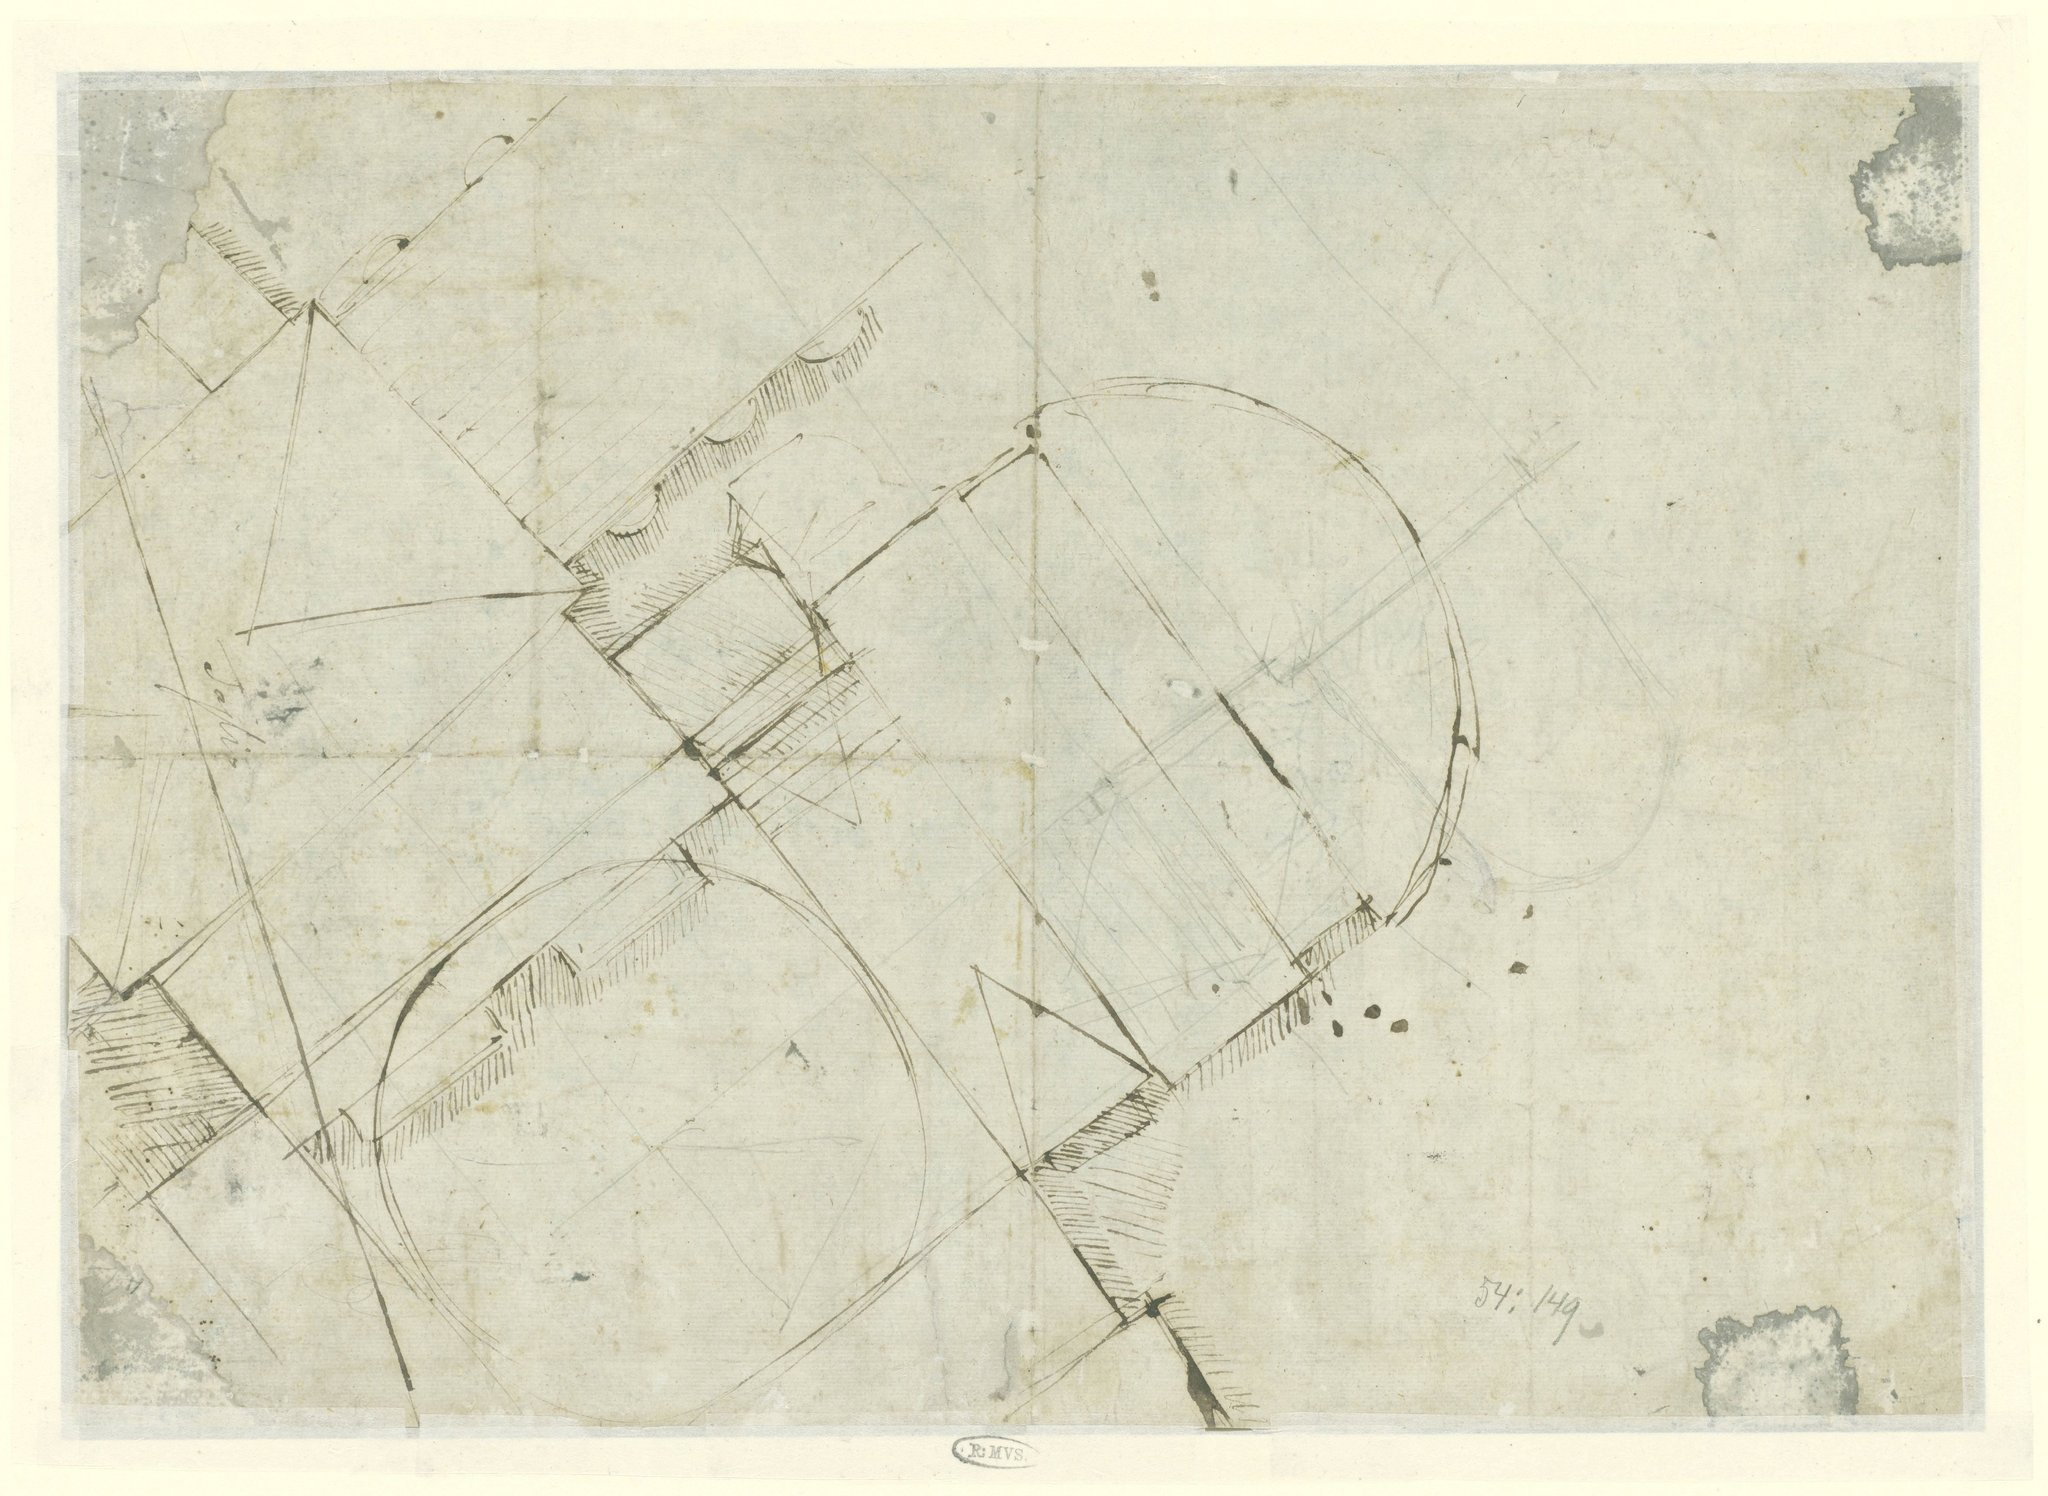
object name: drawing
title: Schets van een plattegrond van een gebouw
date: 1719-1790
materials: ink, paper, pencil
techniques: pen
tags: plan ~ architecture (+ roman art)